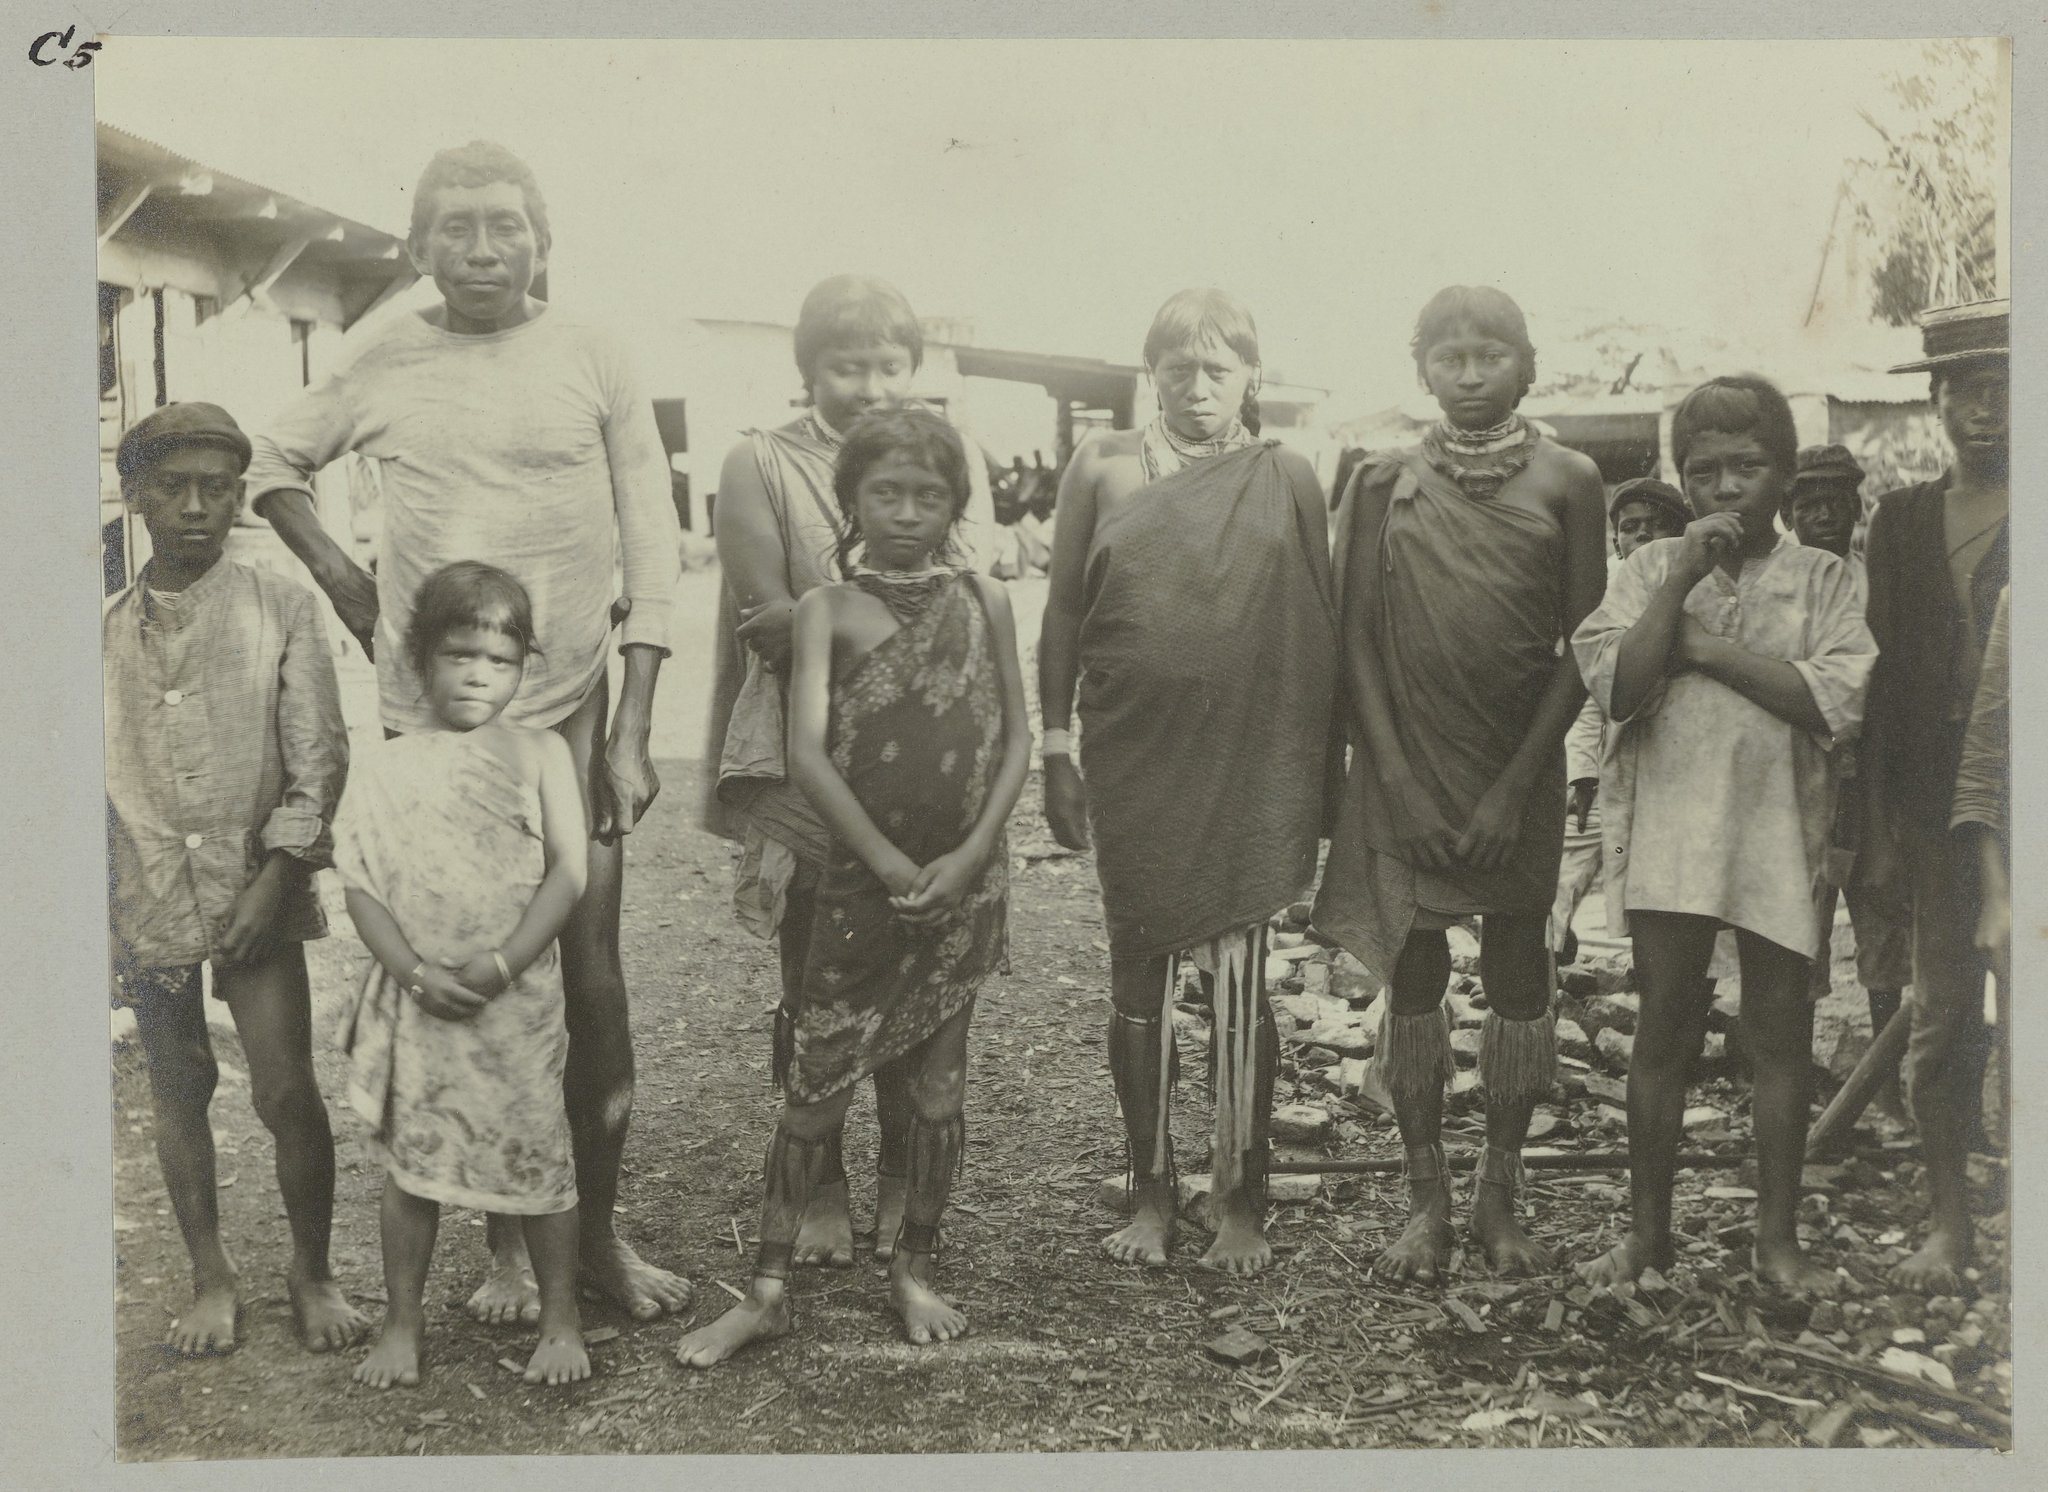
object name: photograph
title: Surinaamse Caraïben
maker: hendrik doijer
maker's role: engineer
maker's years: 1863-1925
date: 1903-1910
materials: photographic support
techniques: gelatin silver print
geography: suriname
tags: indigenous peoples of south america, suriname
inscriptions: inscription: ‘C5 / Caräiben.’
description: Een groep Surinaamse Indiaanse Karaïben. Onderdeel van het fotoalbum Souvenir de Voyage (deel 2), over het leven van de familie Doijer in en rond de plantage Ma Retraite in Suriname in de jaren 1903-1910.